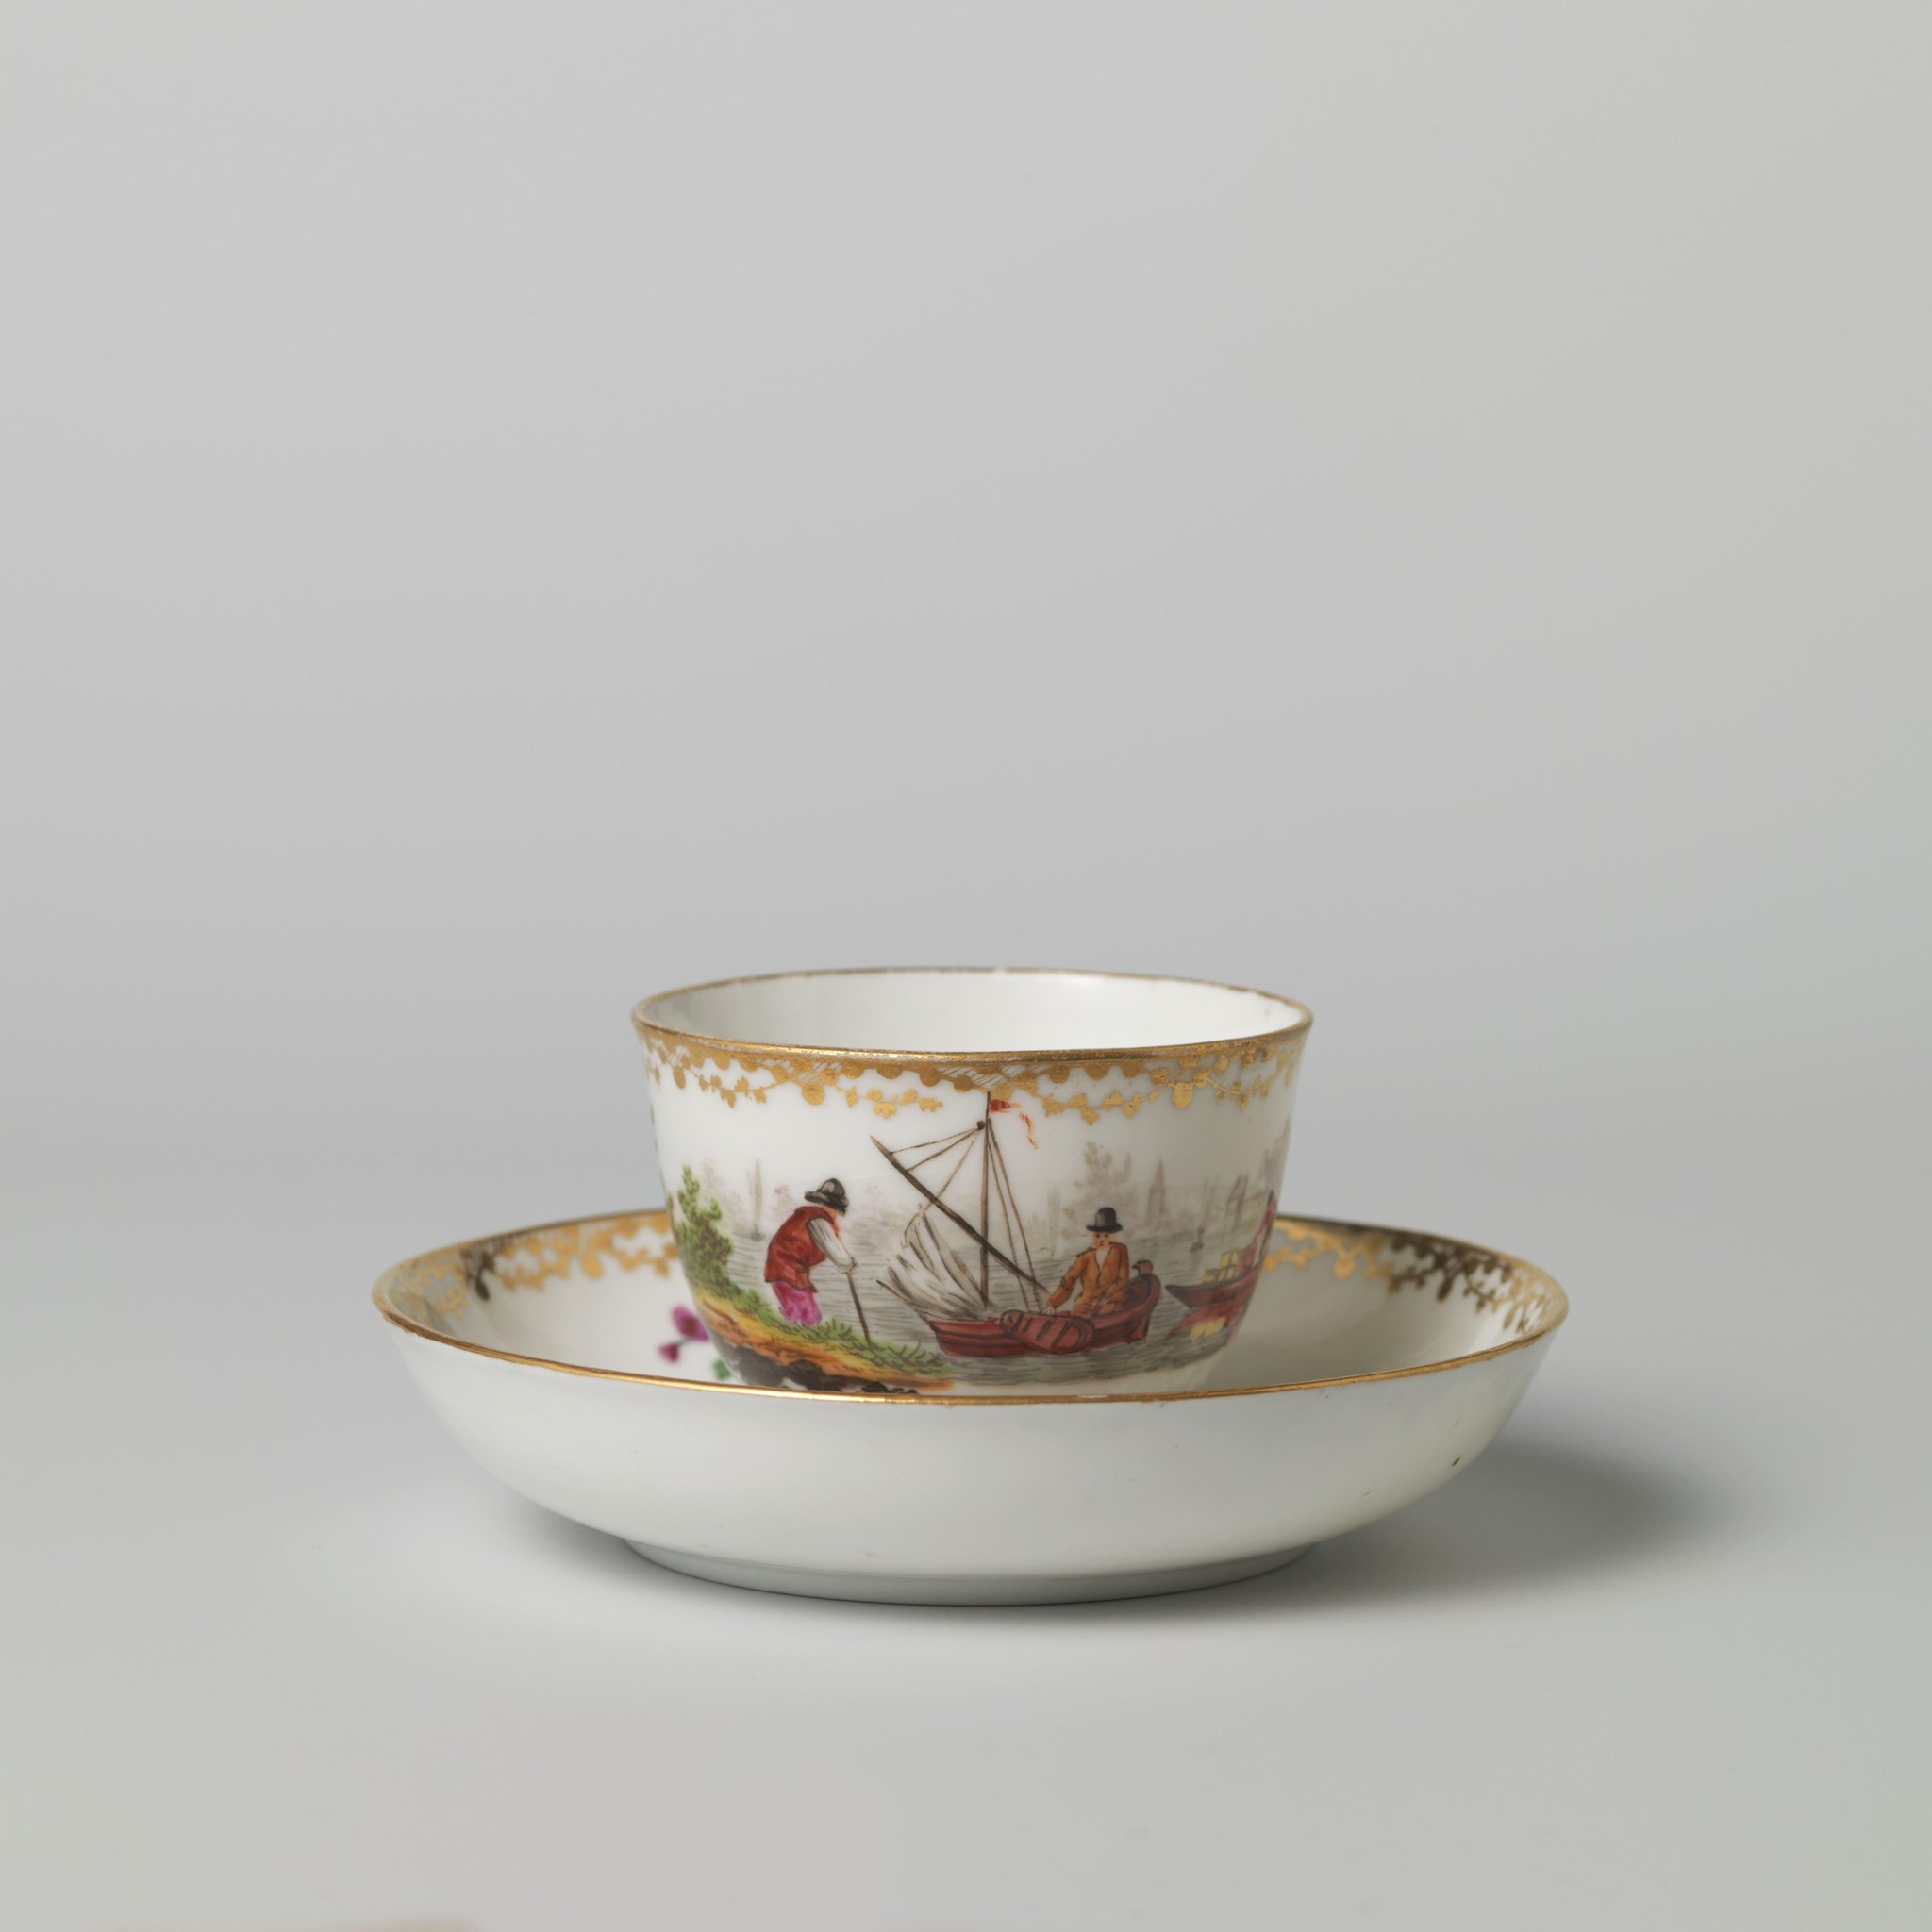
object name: platter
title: Schotel, beschilderd met figuren in een waterlandschap. Bladranken langs de randen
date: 1784-1809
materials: earthenware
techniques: painted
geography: ouder-amstel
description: Schotel veelkleurig beschilderd met figuren in een waterlandschap. Langs de randen, bladranken. Gemerkt: Amstel in zwart.